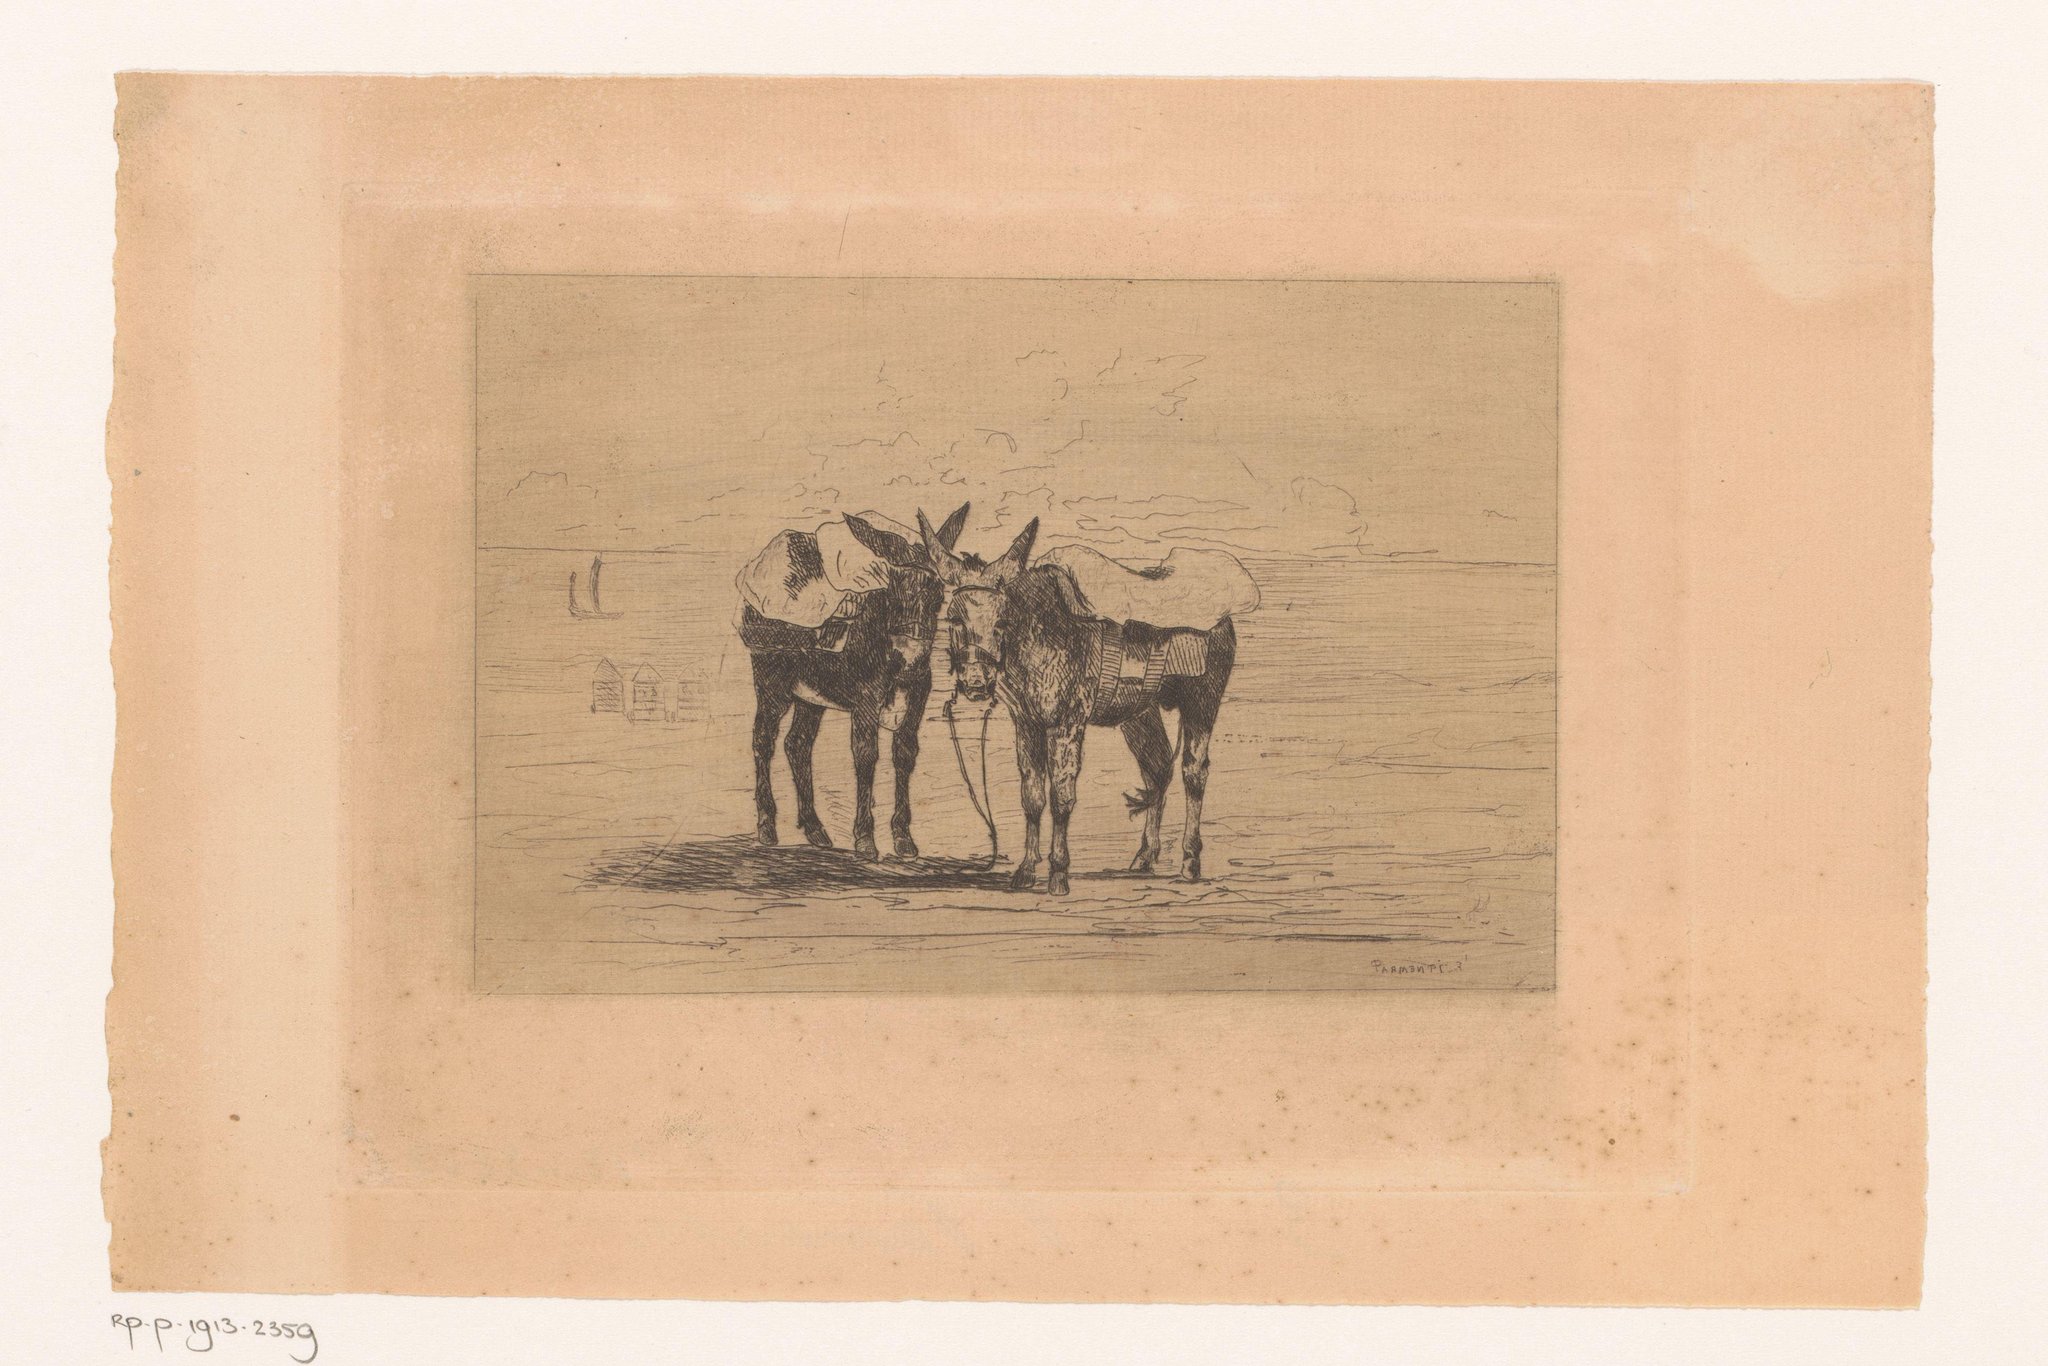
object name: print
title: Twee ezels aan het strand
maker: paul parmentier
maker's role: print maker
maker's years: 1854-1902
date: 1864-1902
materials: paper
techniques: etching, intaglio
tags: ass, donkey, beach, donkey-riding (on the beach)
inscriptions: collector's mark: Lugt 2228